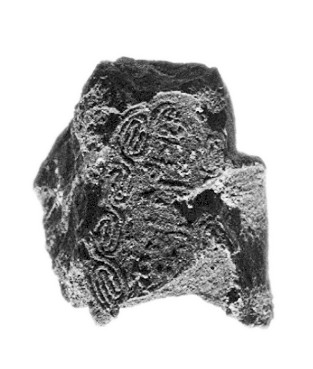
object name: sealing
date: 1981-1640 BCE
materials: mud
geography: egypt